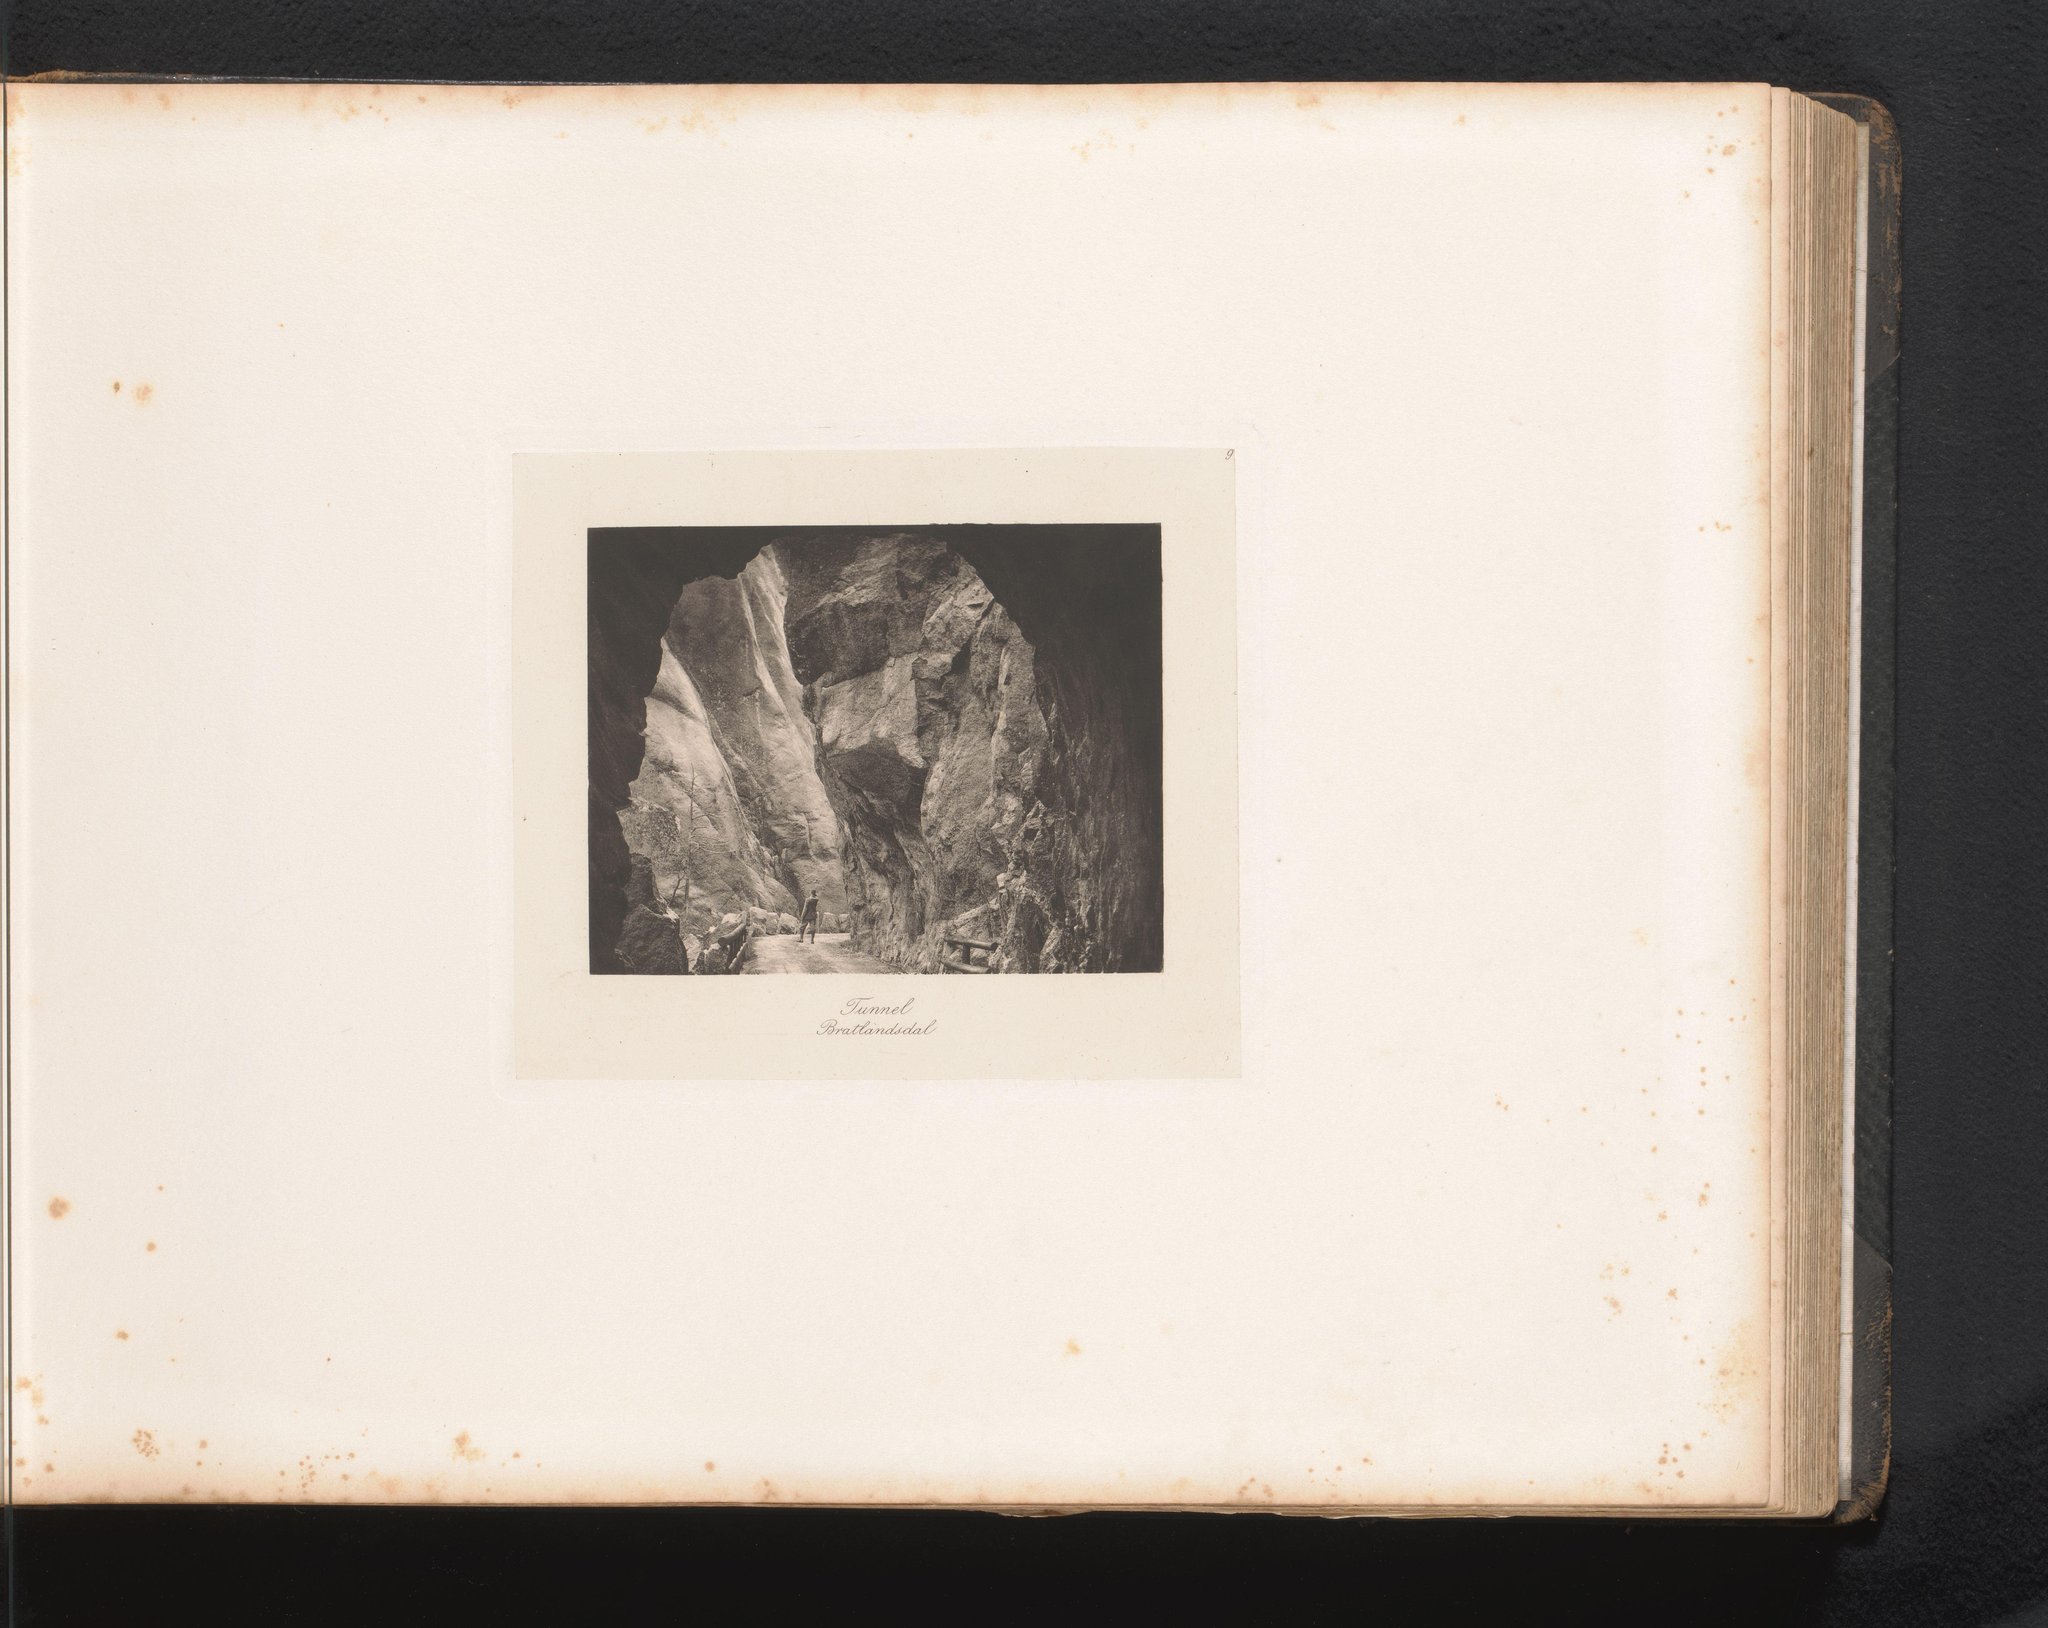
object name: page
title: Tunnel, Bratlandsdal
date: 1888-1893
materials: paper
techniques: photograph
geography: vienna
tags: underground road, tunnel, mountains (+ landscape with figures, staffage)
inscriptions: number: ‘9’